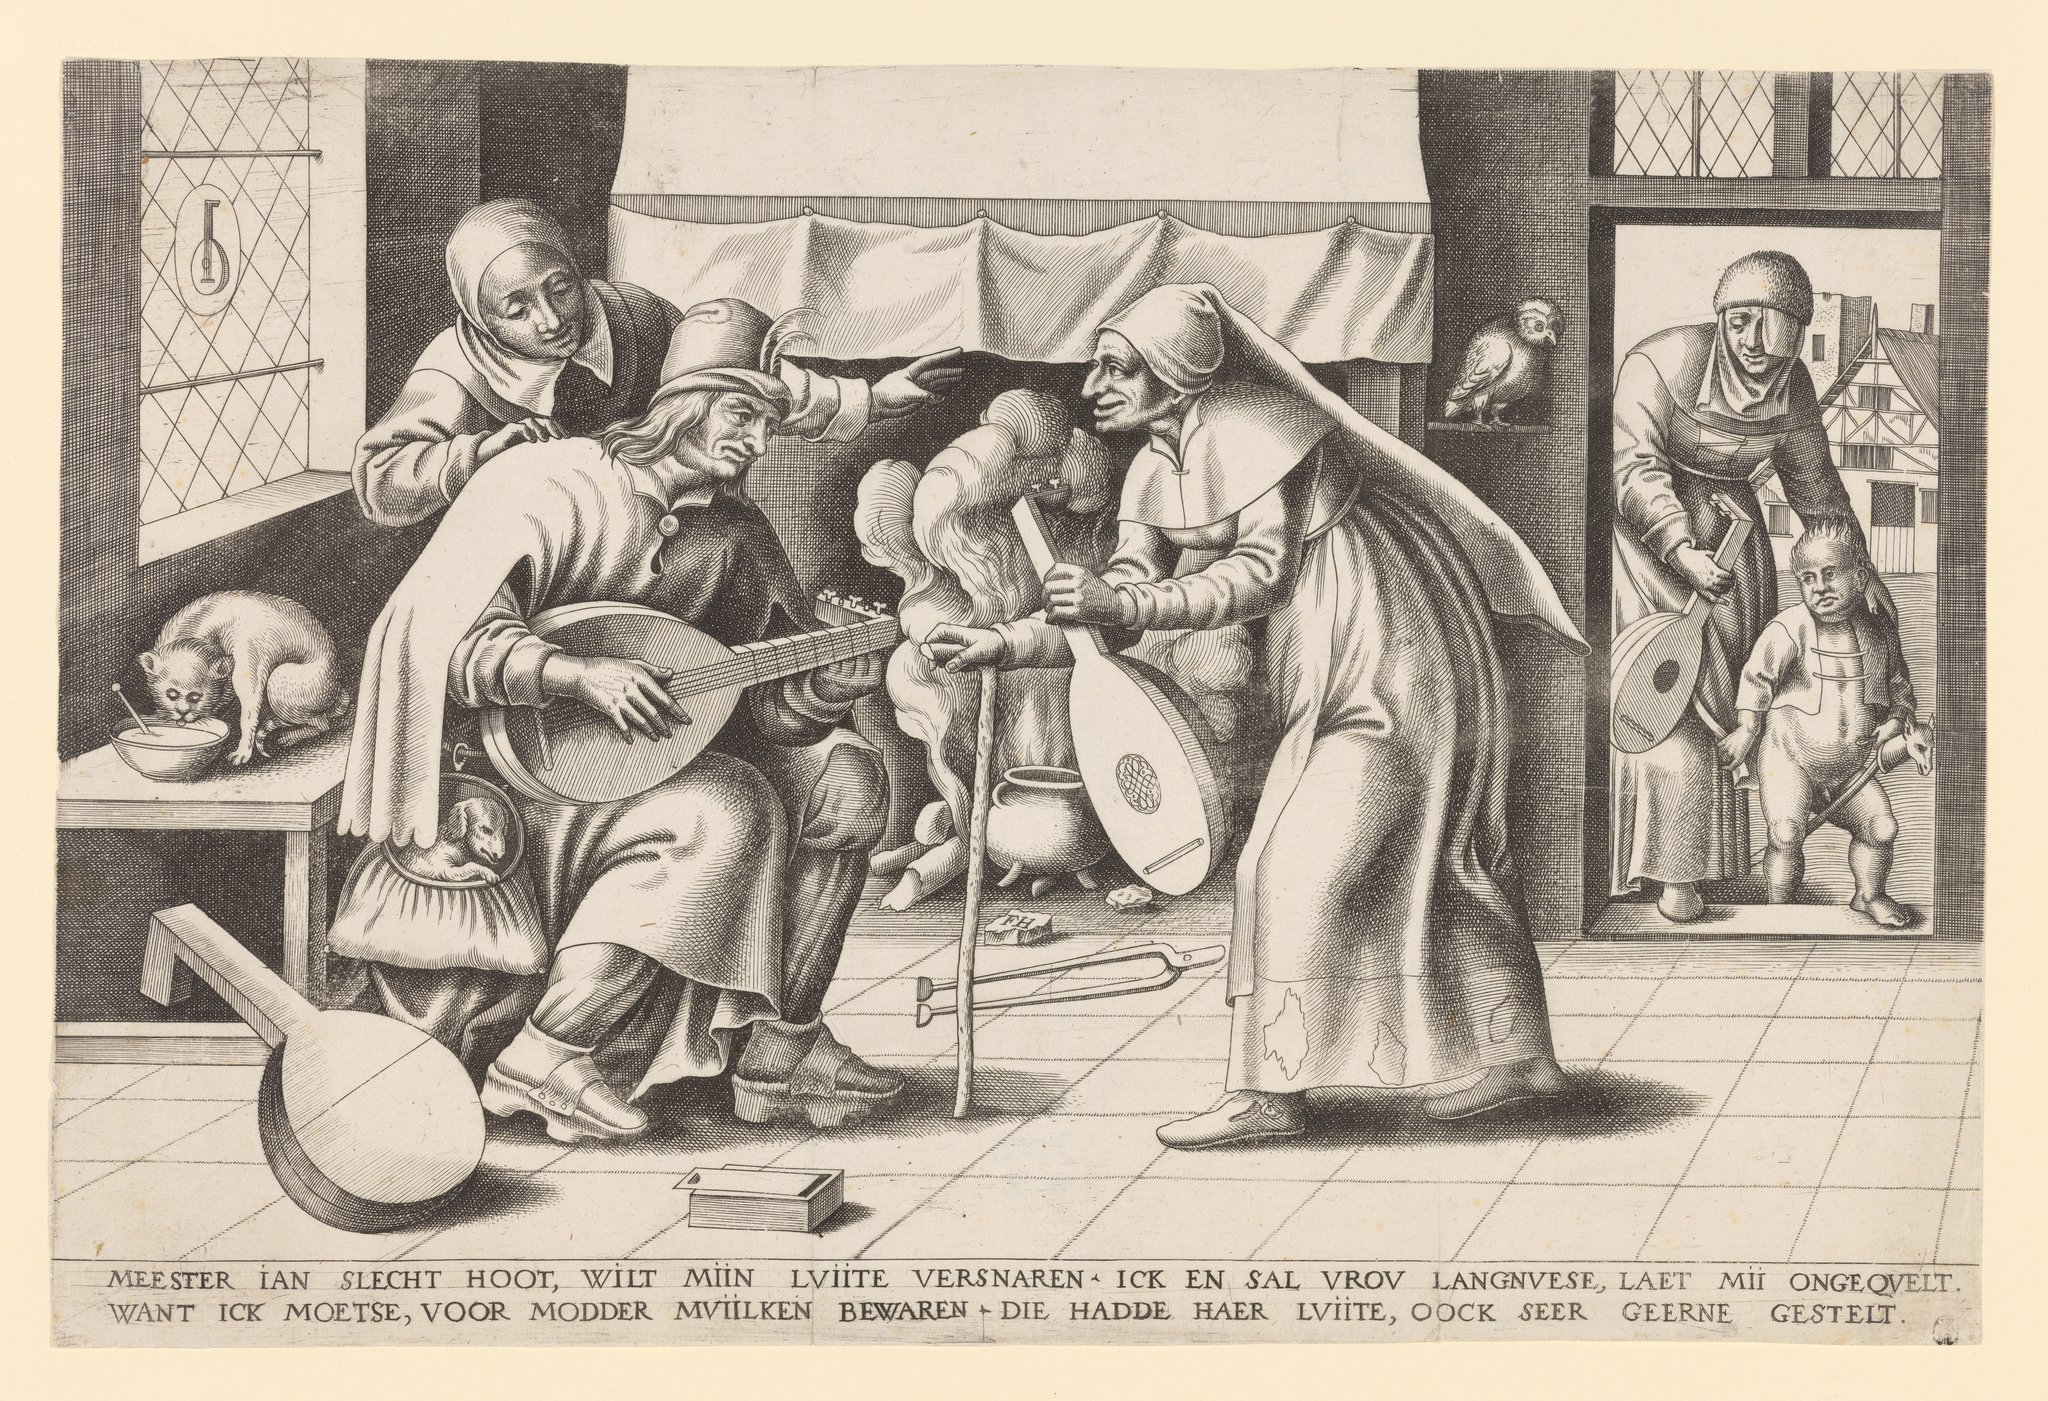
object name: print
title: Master John Blockhead or The Lute Maker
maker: frans huys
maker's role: artist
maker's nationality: netherlandish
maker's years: 1522-1562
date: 1534-1566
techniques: engraving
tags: musical instruments,men,women,lutes,cats